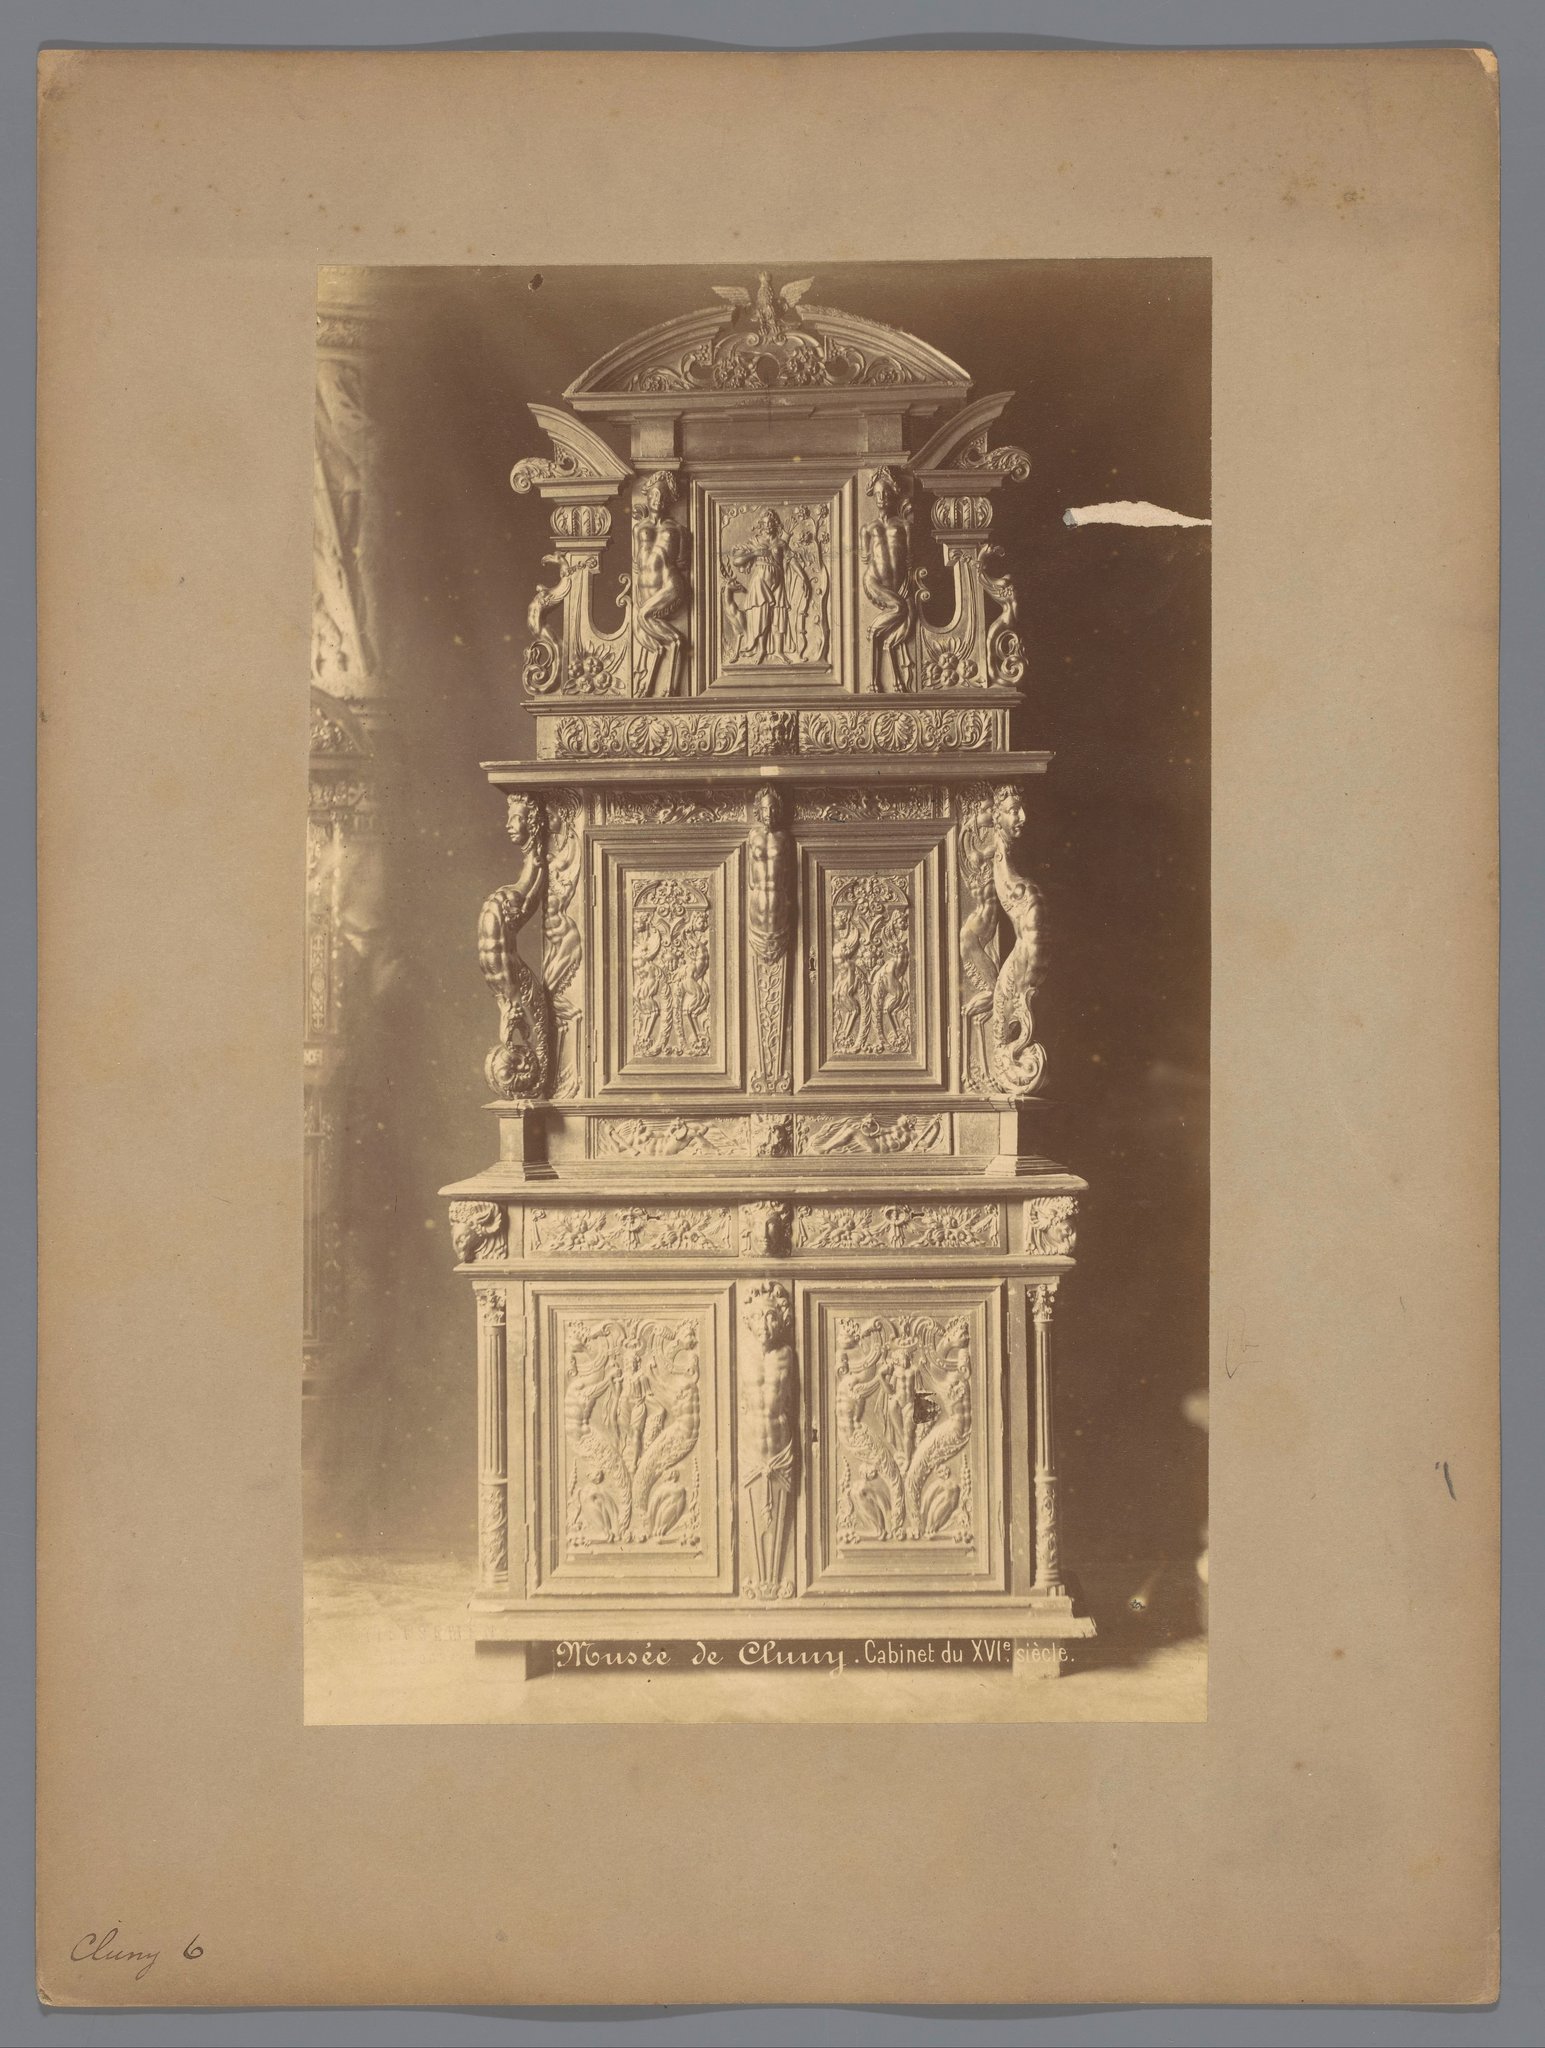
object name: photograph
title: Musée de Cluny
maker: séraphin-médéric mieusement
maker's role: fotograaf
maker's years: 1840-1905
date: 1850-1900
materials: cardboard, photographic support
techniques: albumen print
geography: paris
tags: ornamental cupboard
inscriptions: collector's mark: ‘Rijks-normaalschool voor teekenonderwijzers Amsterdam’ Lugt 3937, number: ‘Cluny’, workshop stamp: ‘Mieusement/ Photographe’